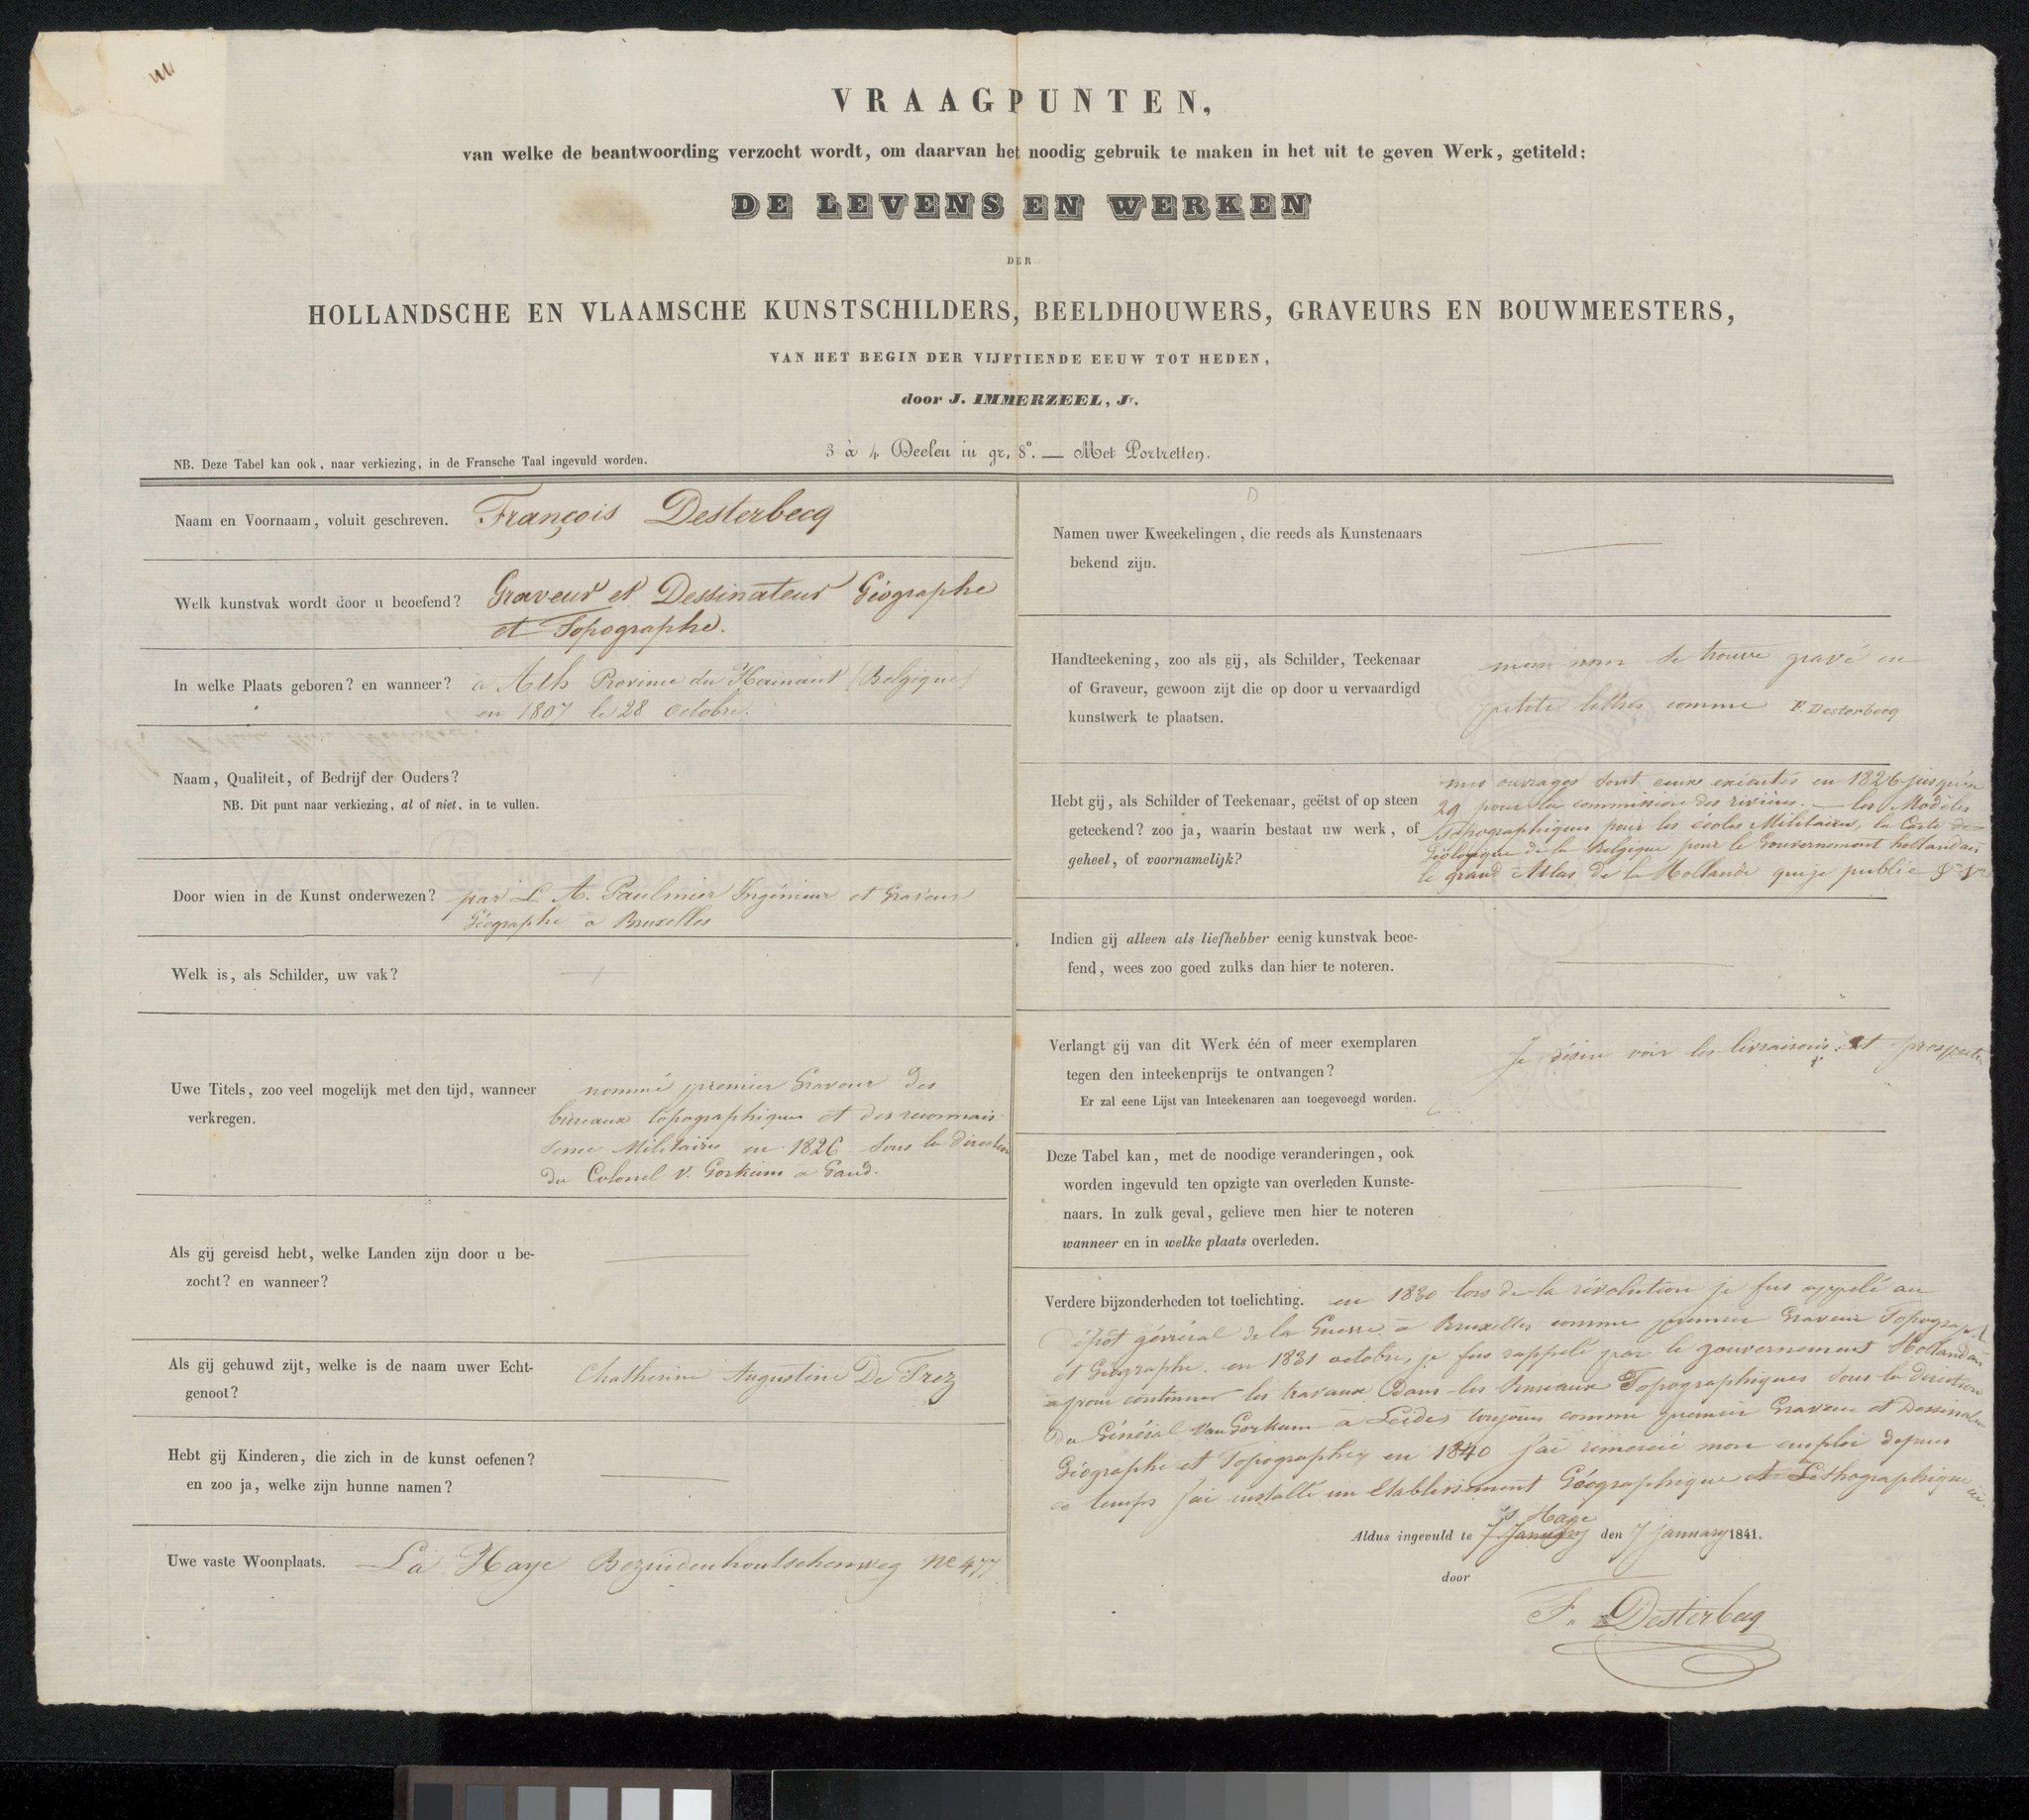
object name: manuscript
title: Enquêteformulier ingevuld door François Desterbecq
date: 1841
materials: ink, paper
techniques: pen, printing, writing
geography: the hague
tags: françois desterbecq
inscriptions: inscription: ‘Vraagpunten,/ van welke de beantwoording verzocht wordt, om daarvan het noodig gebruik te maken in het uit te geven Werk, getiteld: De levens en werken/ der Hollandsche en Vlaamsche kunstschilders, beeldhouwers,/ graveurs en bouwmeesters, van het begin der vijftiende eeuw tot heden/ door J. Immerzeel, Jr.’, watermark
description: Opgenomen in: Immerzeel, J. Jr., De levens en werken der Hollandsche en Vlaamsche kunstschilders, beeldhouwers, graveurs en bouwmeesters, van het begin der vijftiende eeuw tot heden, Amsterdam: J.C. van Kesteren, 1842-1843.